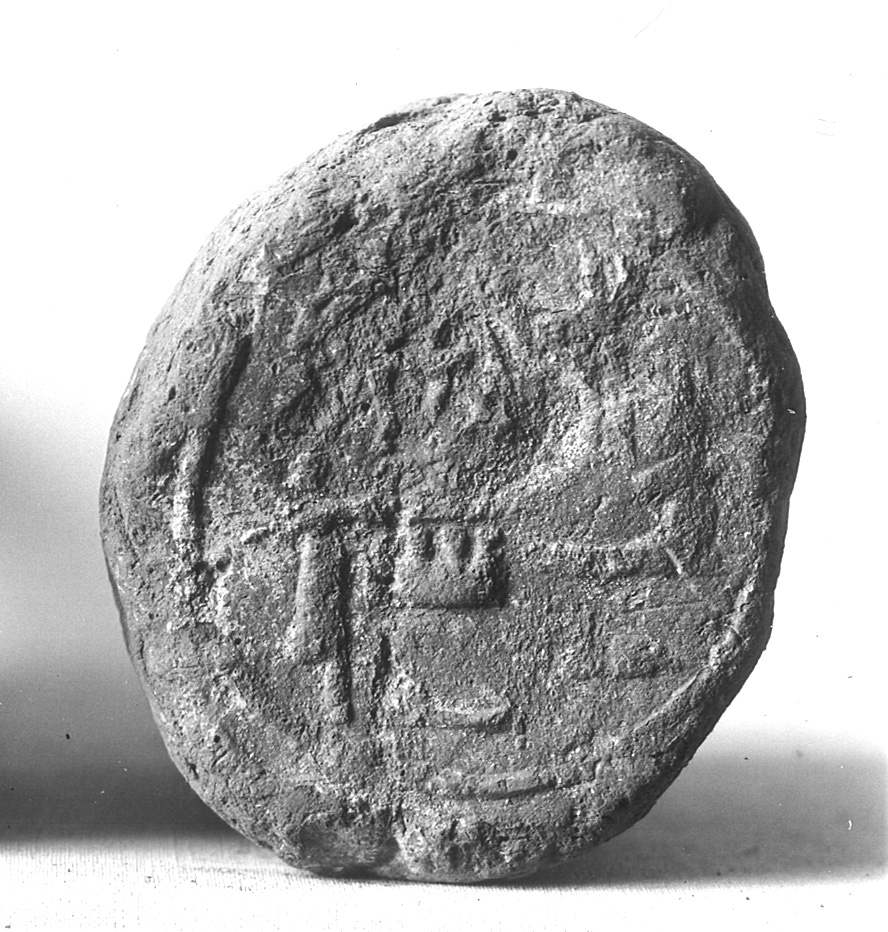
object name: cone, circular impression, userhat, overseer, cattle of amun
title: Funerary Cone of the Overseer Userhat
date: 1550-1352 BCE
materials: pottery